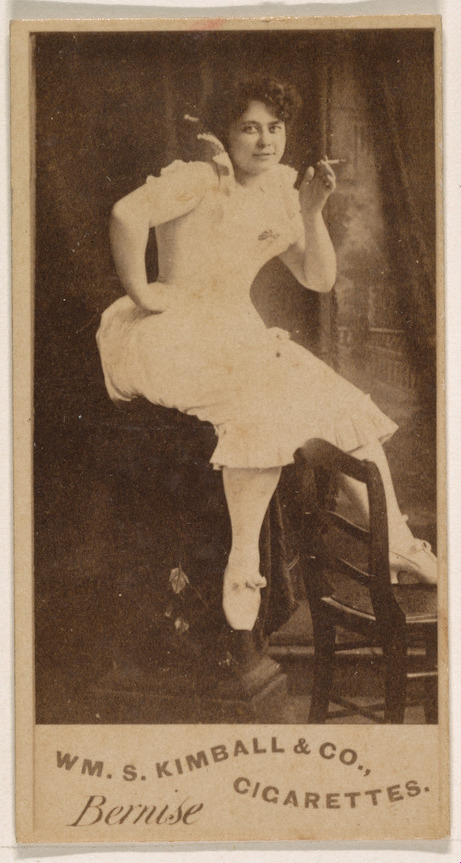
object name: photograph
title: Miss Bernise, from the Actresses series (N203) issued by Wm. S. Kimball & Co.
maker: william s. kimball & company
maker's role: publisher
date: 1889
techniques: color lithograph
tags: portraits,women,smoking,actresses